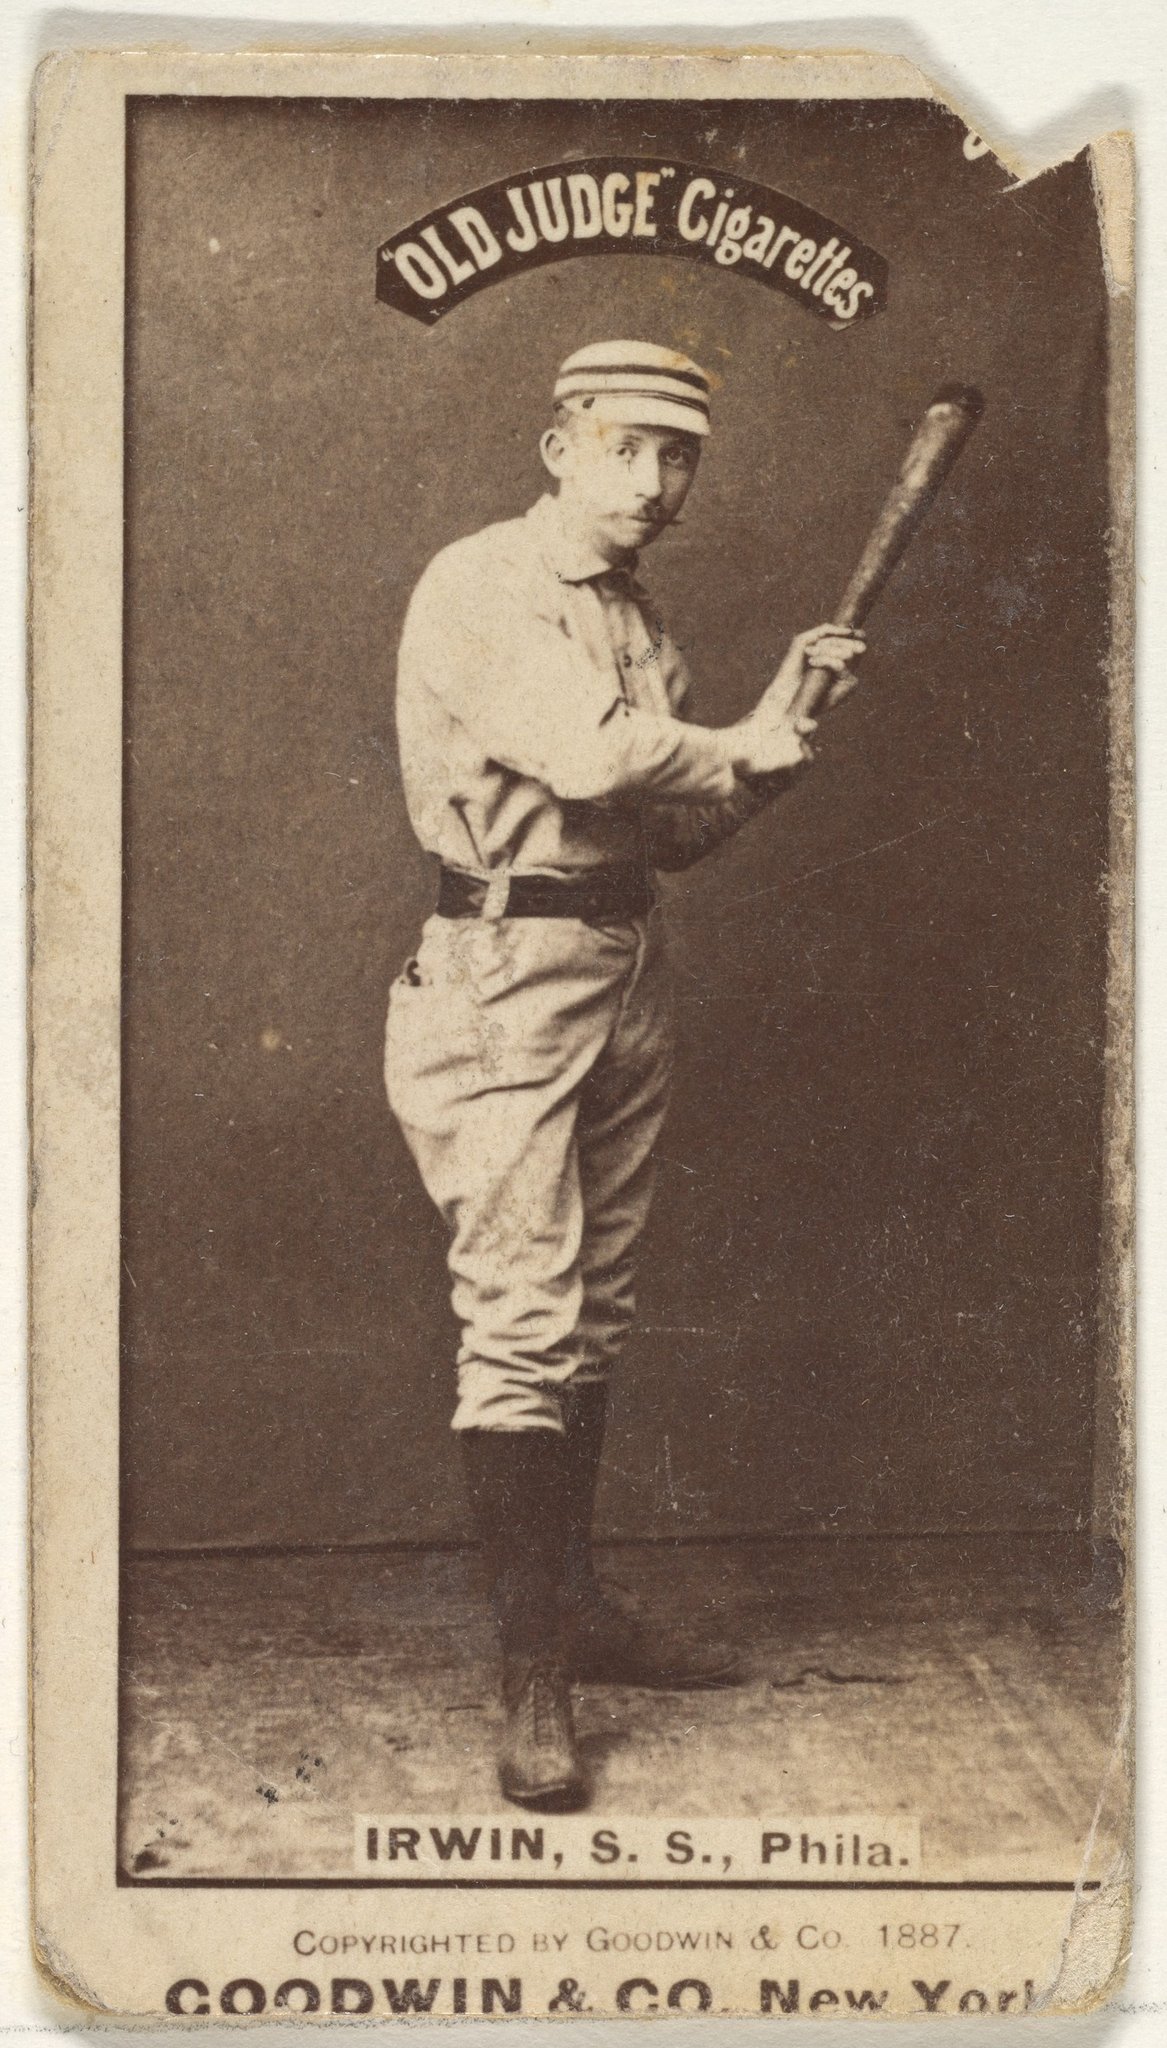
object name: baseball card, photograph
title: Arthur Albert "Doc" Irwin, Shortstop, Philadelphia, from the Old Judge series (N172) for Old Judge Cigarettes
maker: goodwin & company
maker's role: publisher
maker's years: 1850-1950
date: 1887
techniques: albumen silver print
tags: men,portraits,baseball,athletes